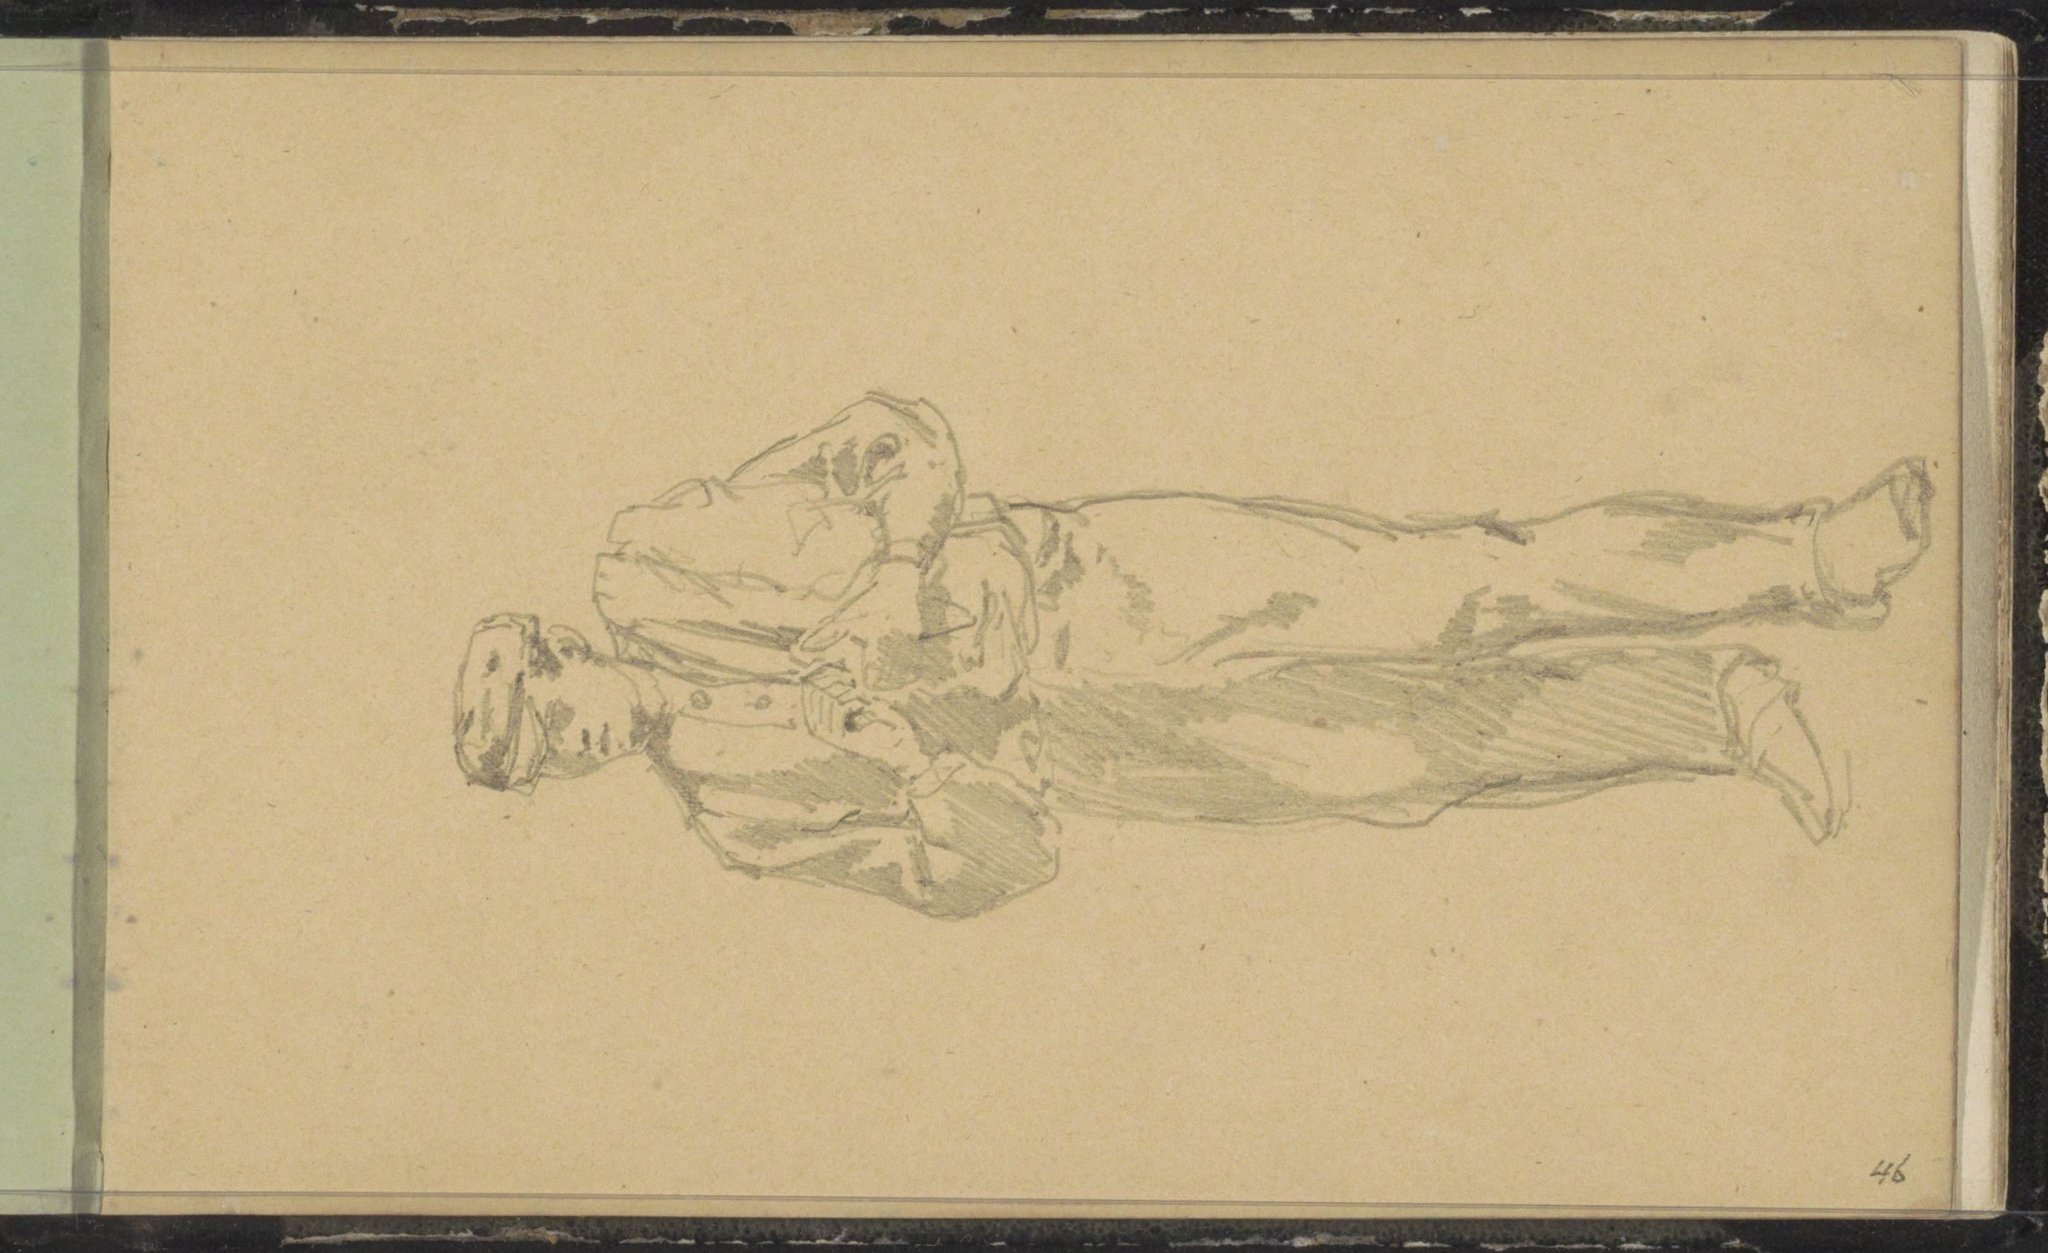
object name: sketchbook leaf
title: Man met een pet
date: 1863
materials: paper, pencil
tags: standing figure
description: Staande man met een pet. Blad 46 recto uit een schetsboek met 55 bladen vervaardigd op de Veluwe en in Noord-Duitsland.